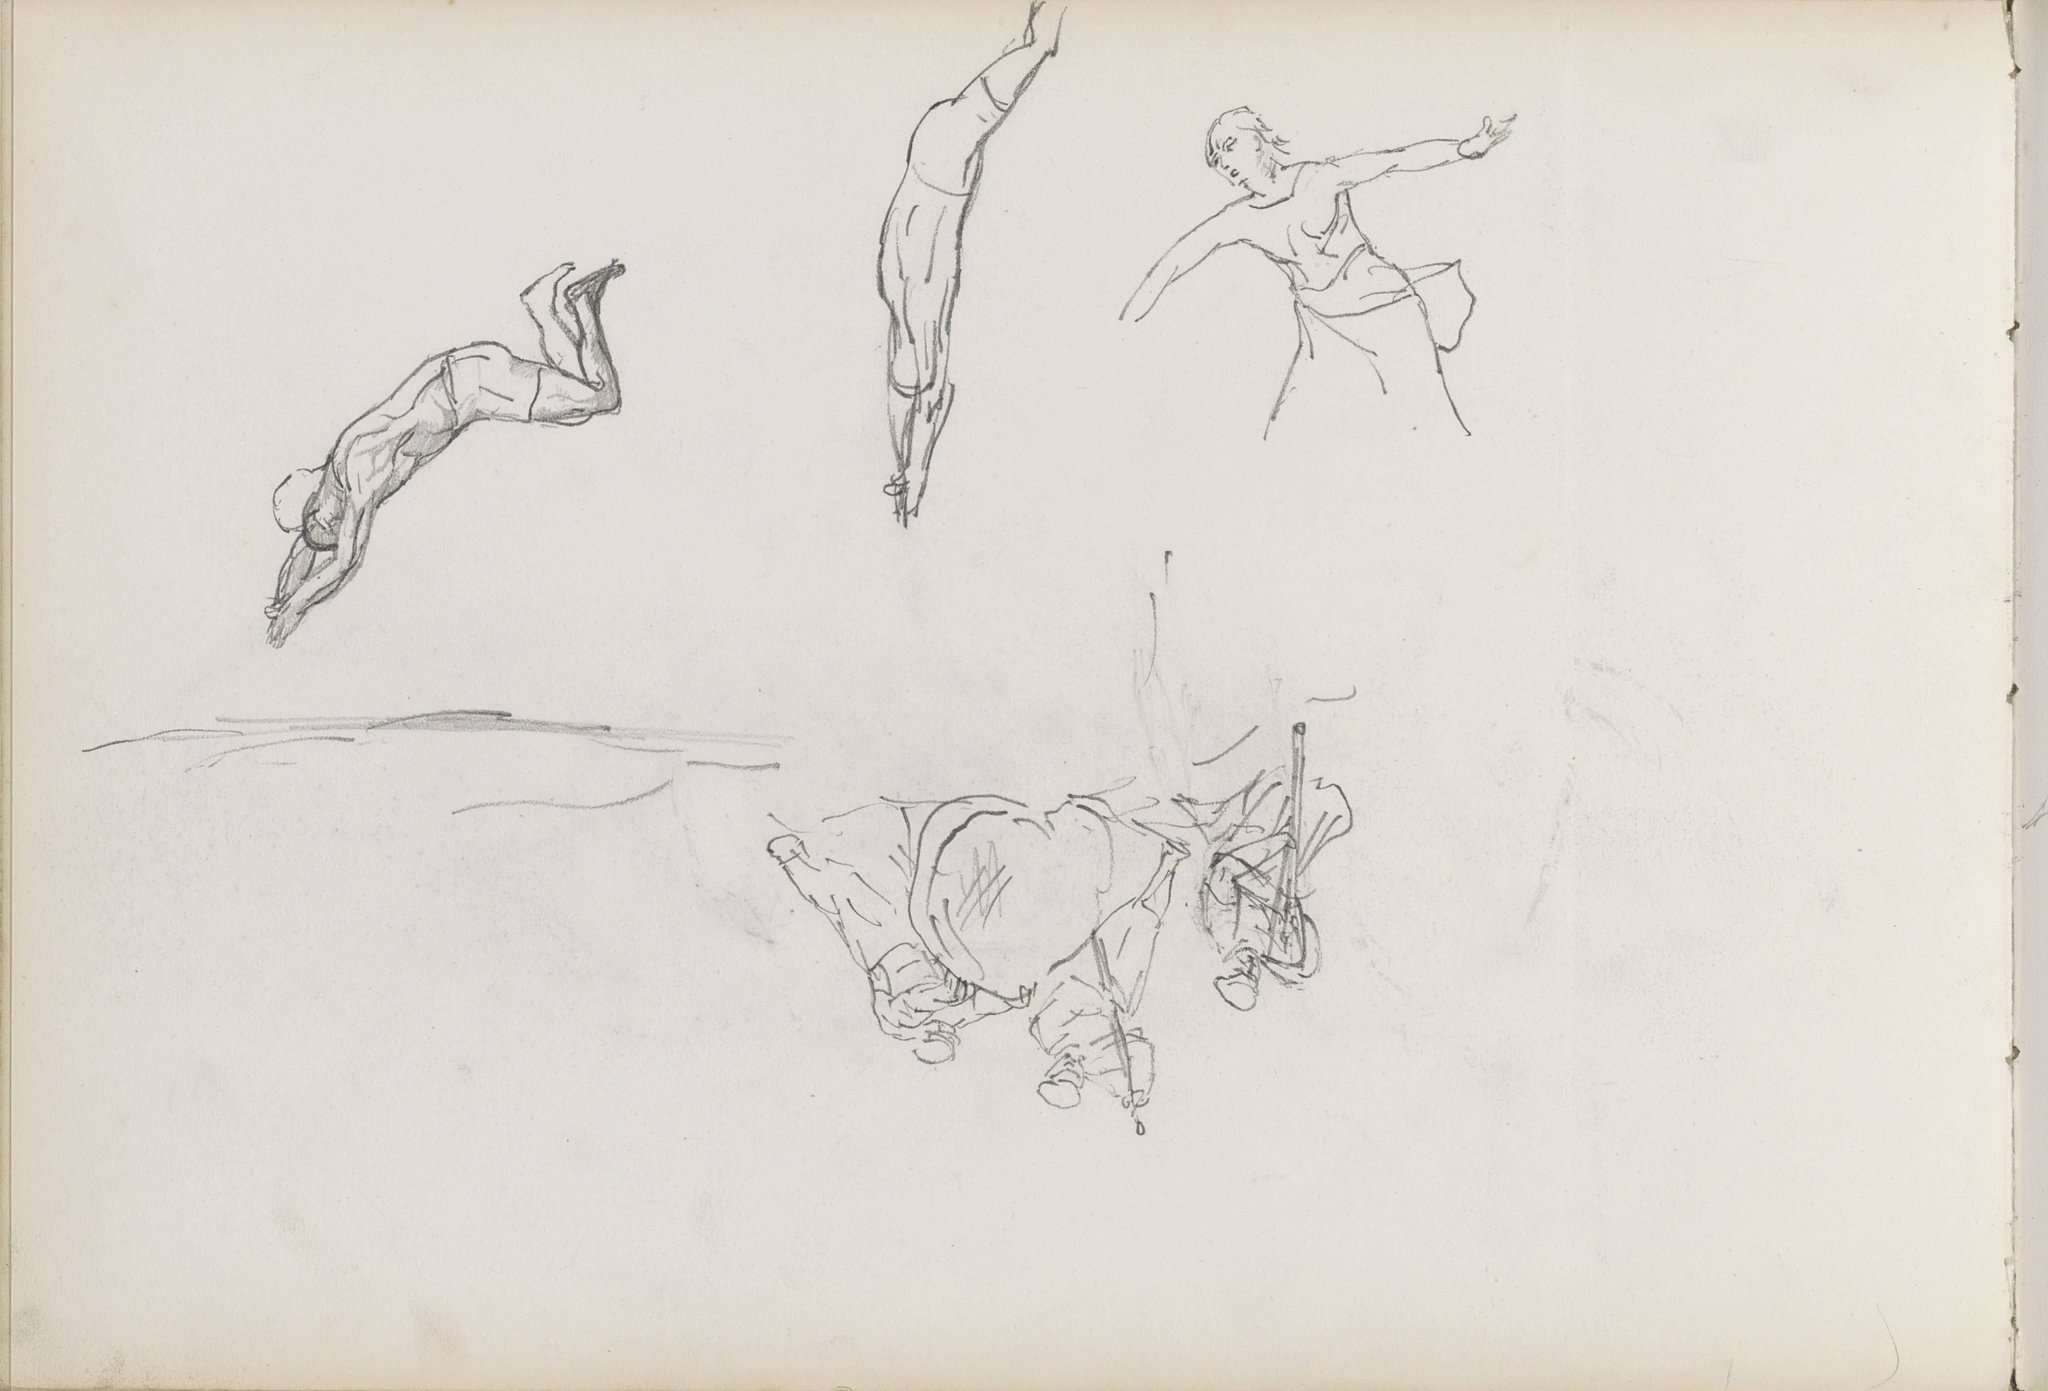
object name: sketchbook leaf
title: Soldaten en duikende figuren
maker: george hendrik breitner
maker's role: draughtsman, painter, print maker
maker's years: 1857-1923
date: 1873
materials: paper, pencil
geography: rotterdam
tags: diving (movement in water), division of armed forces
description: De soldaten laden mogelijk hun geweer. Blad 12 verso uit een schetsboek met 25 bladen.